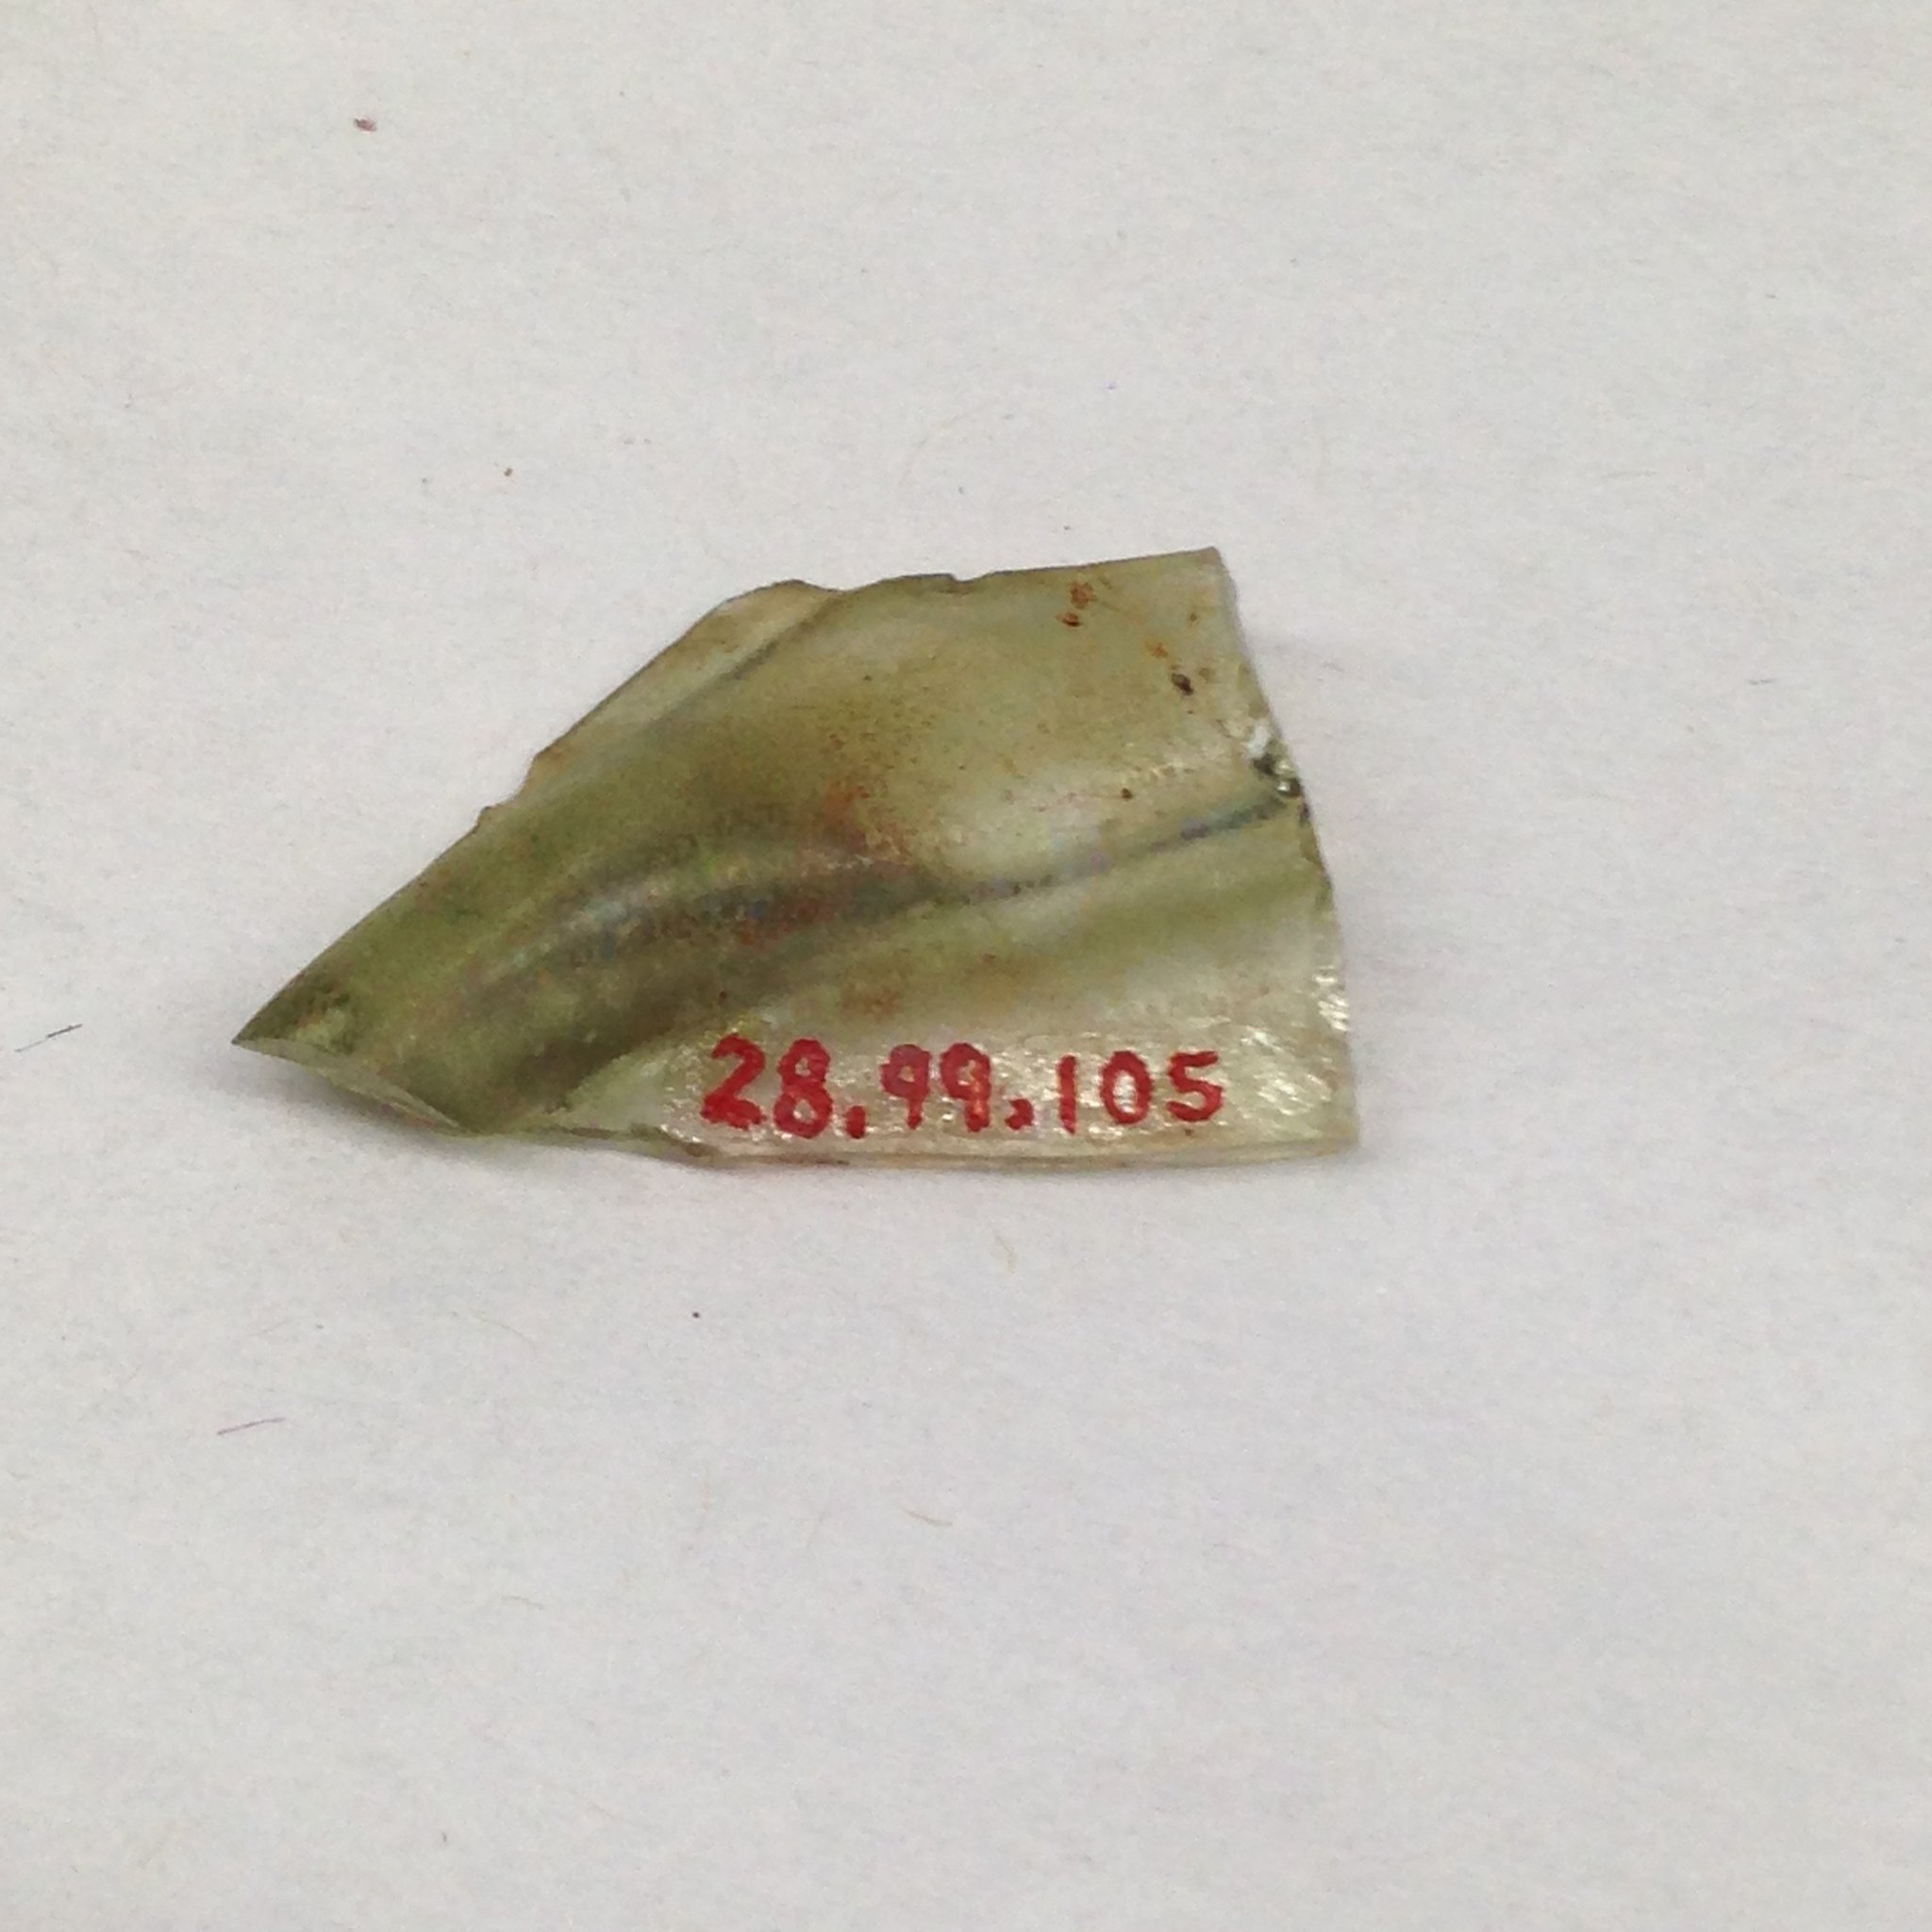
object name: fragment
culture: european or middle eastern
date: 1150-1250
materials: ceramic, glass